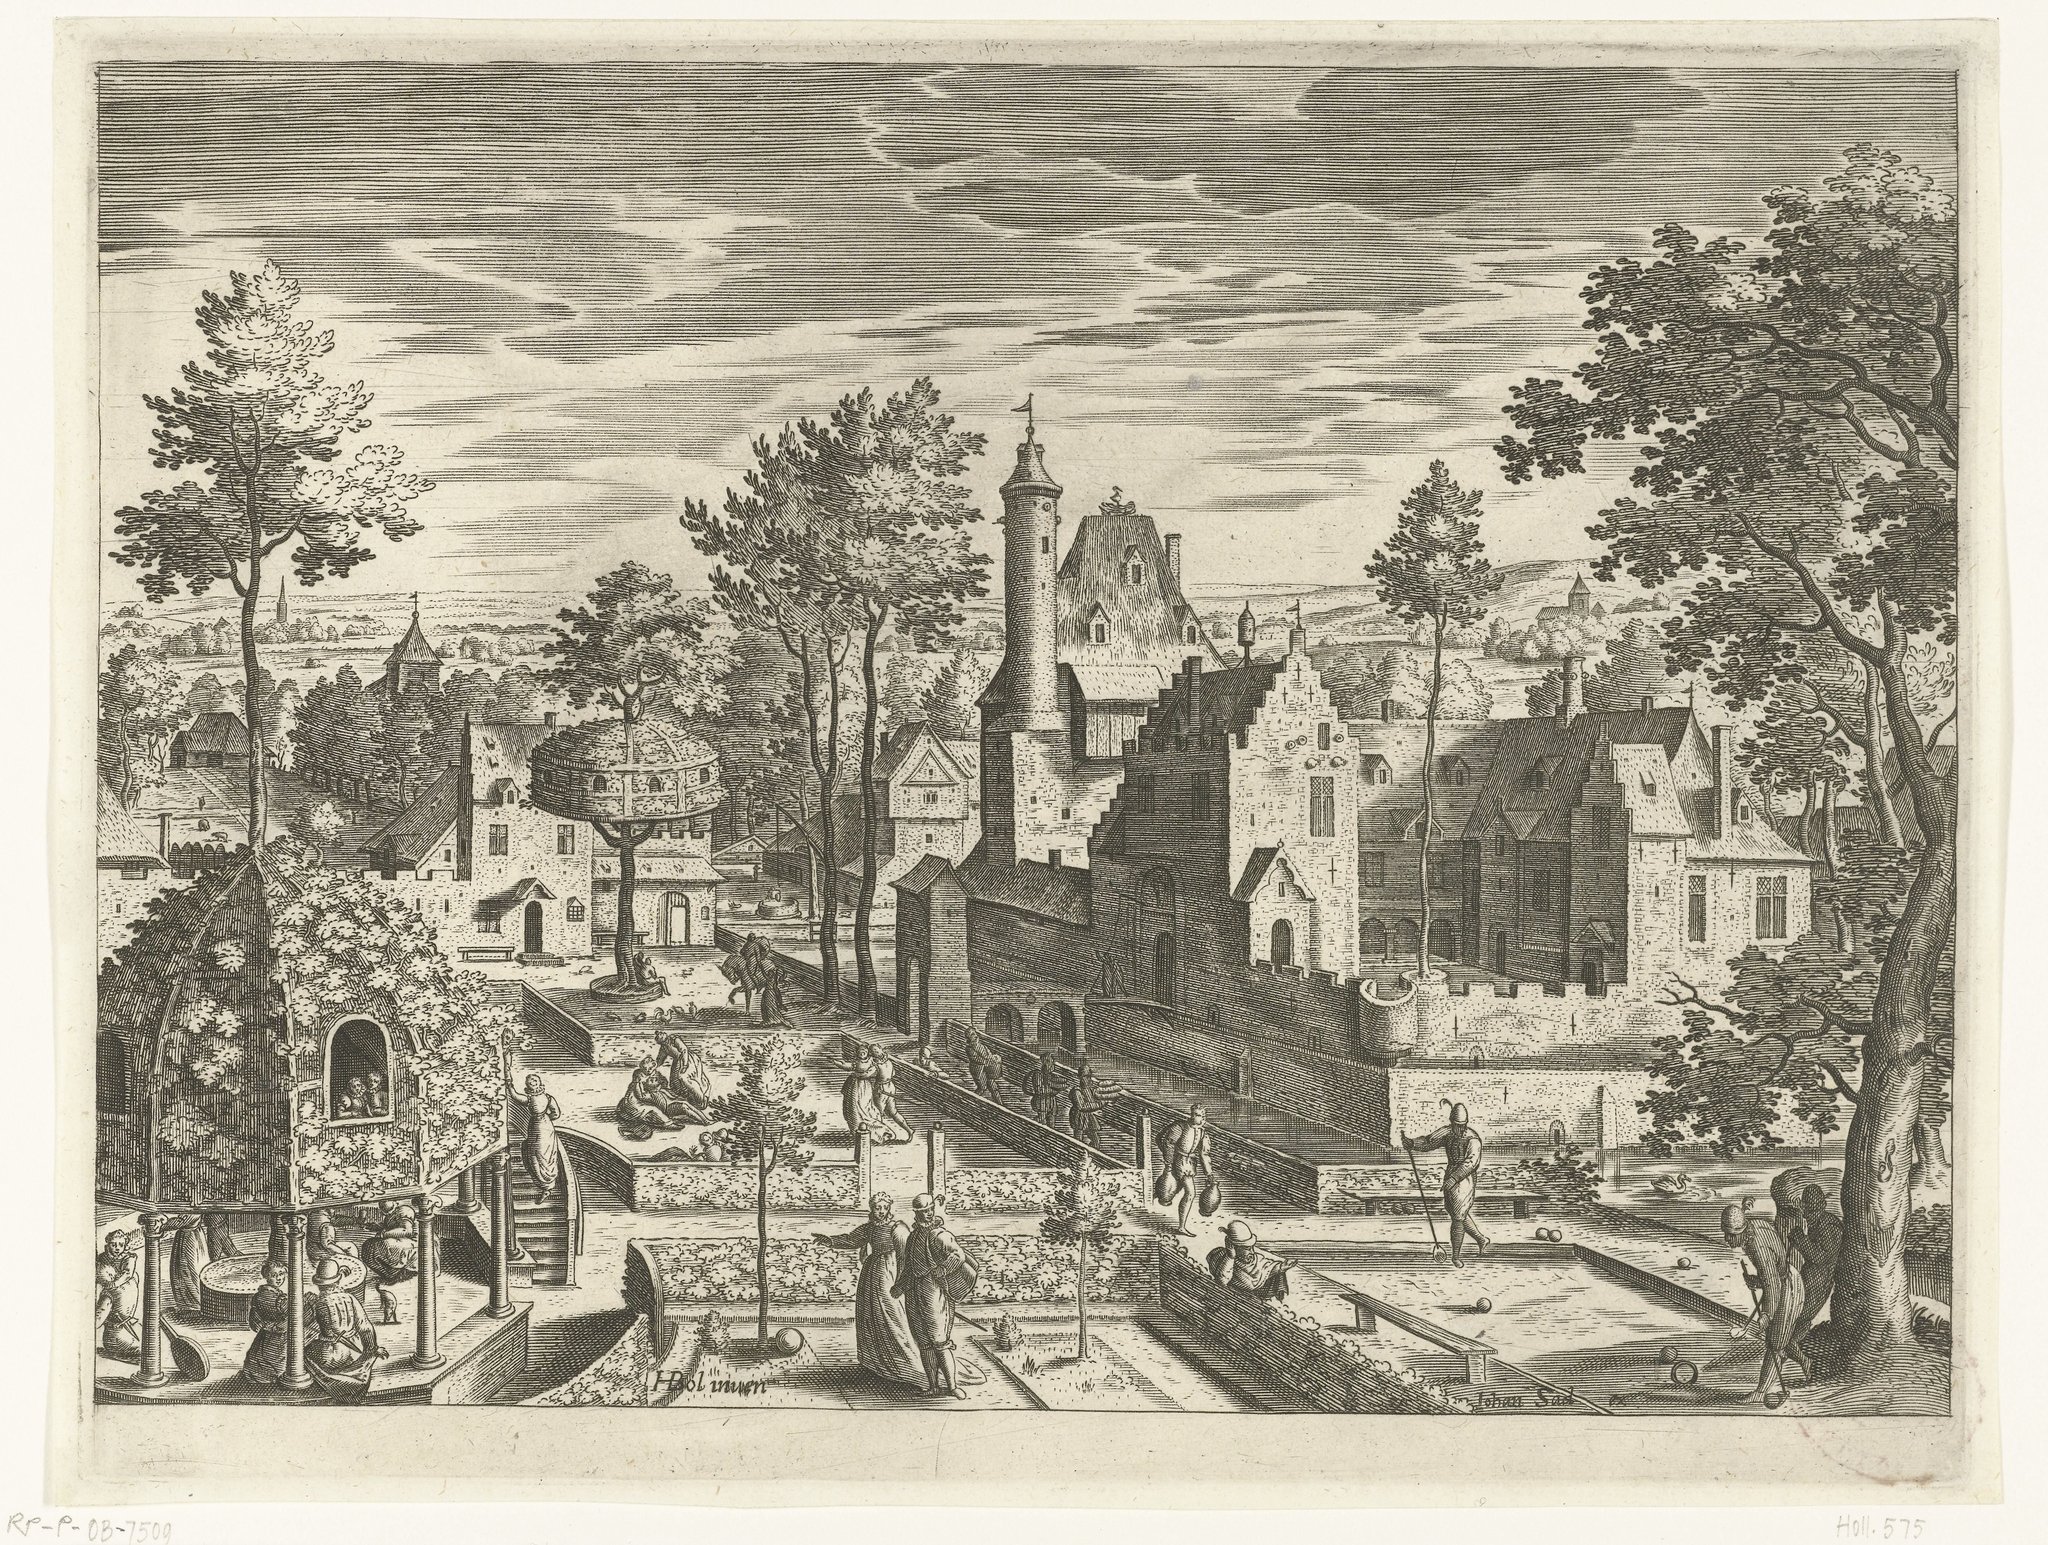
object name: print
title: Vier landschappen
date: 1560-1600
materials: paper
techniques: engraving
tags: castle, french or architectonic garden; formal garden, summer-house, arbour, garden-house (dutch: 'theekoepel')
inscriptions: collector's mark: Lugt 240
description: Gezicht op de tuin van een kasteel of een buitenverblijf. Verschillende wandelaars en paartjes verkennen de tuin. Rechts op de voorgrond een paviljoen. Op de achtergrond rechts het kasteel. De prent maakt deel uit van een vierdelige serie met landschappen.